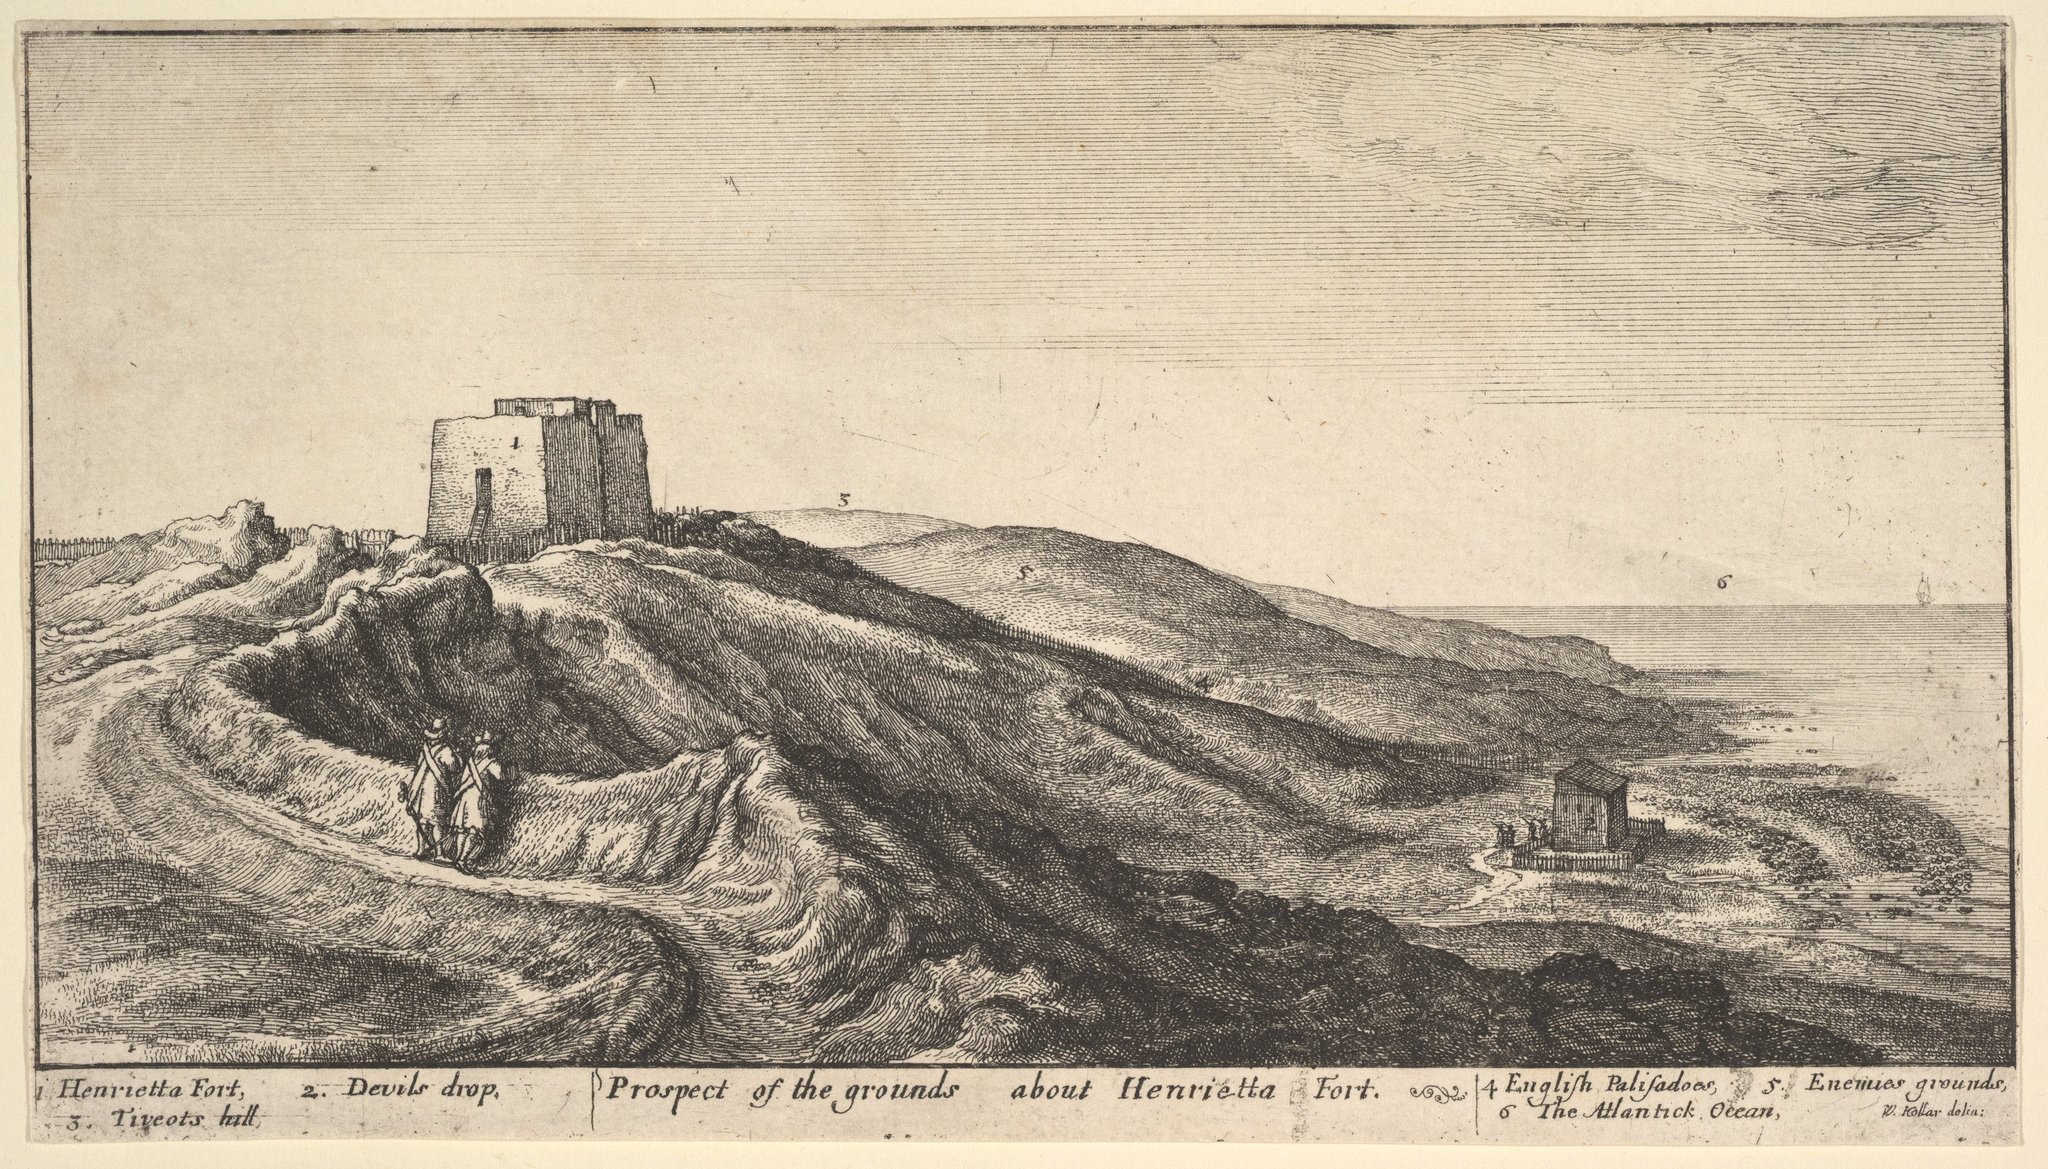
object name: print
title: Henrietta Fort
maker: wenceslaus hollar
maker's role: artist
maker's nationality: bohemian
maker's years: 1607-1677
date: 1670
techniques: etching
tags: buildings,soldiers